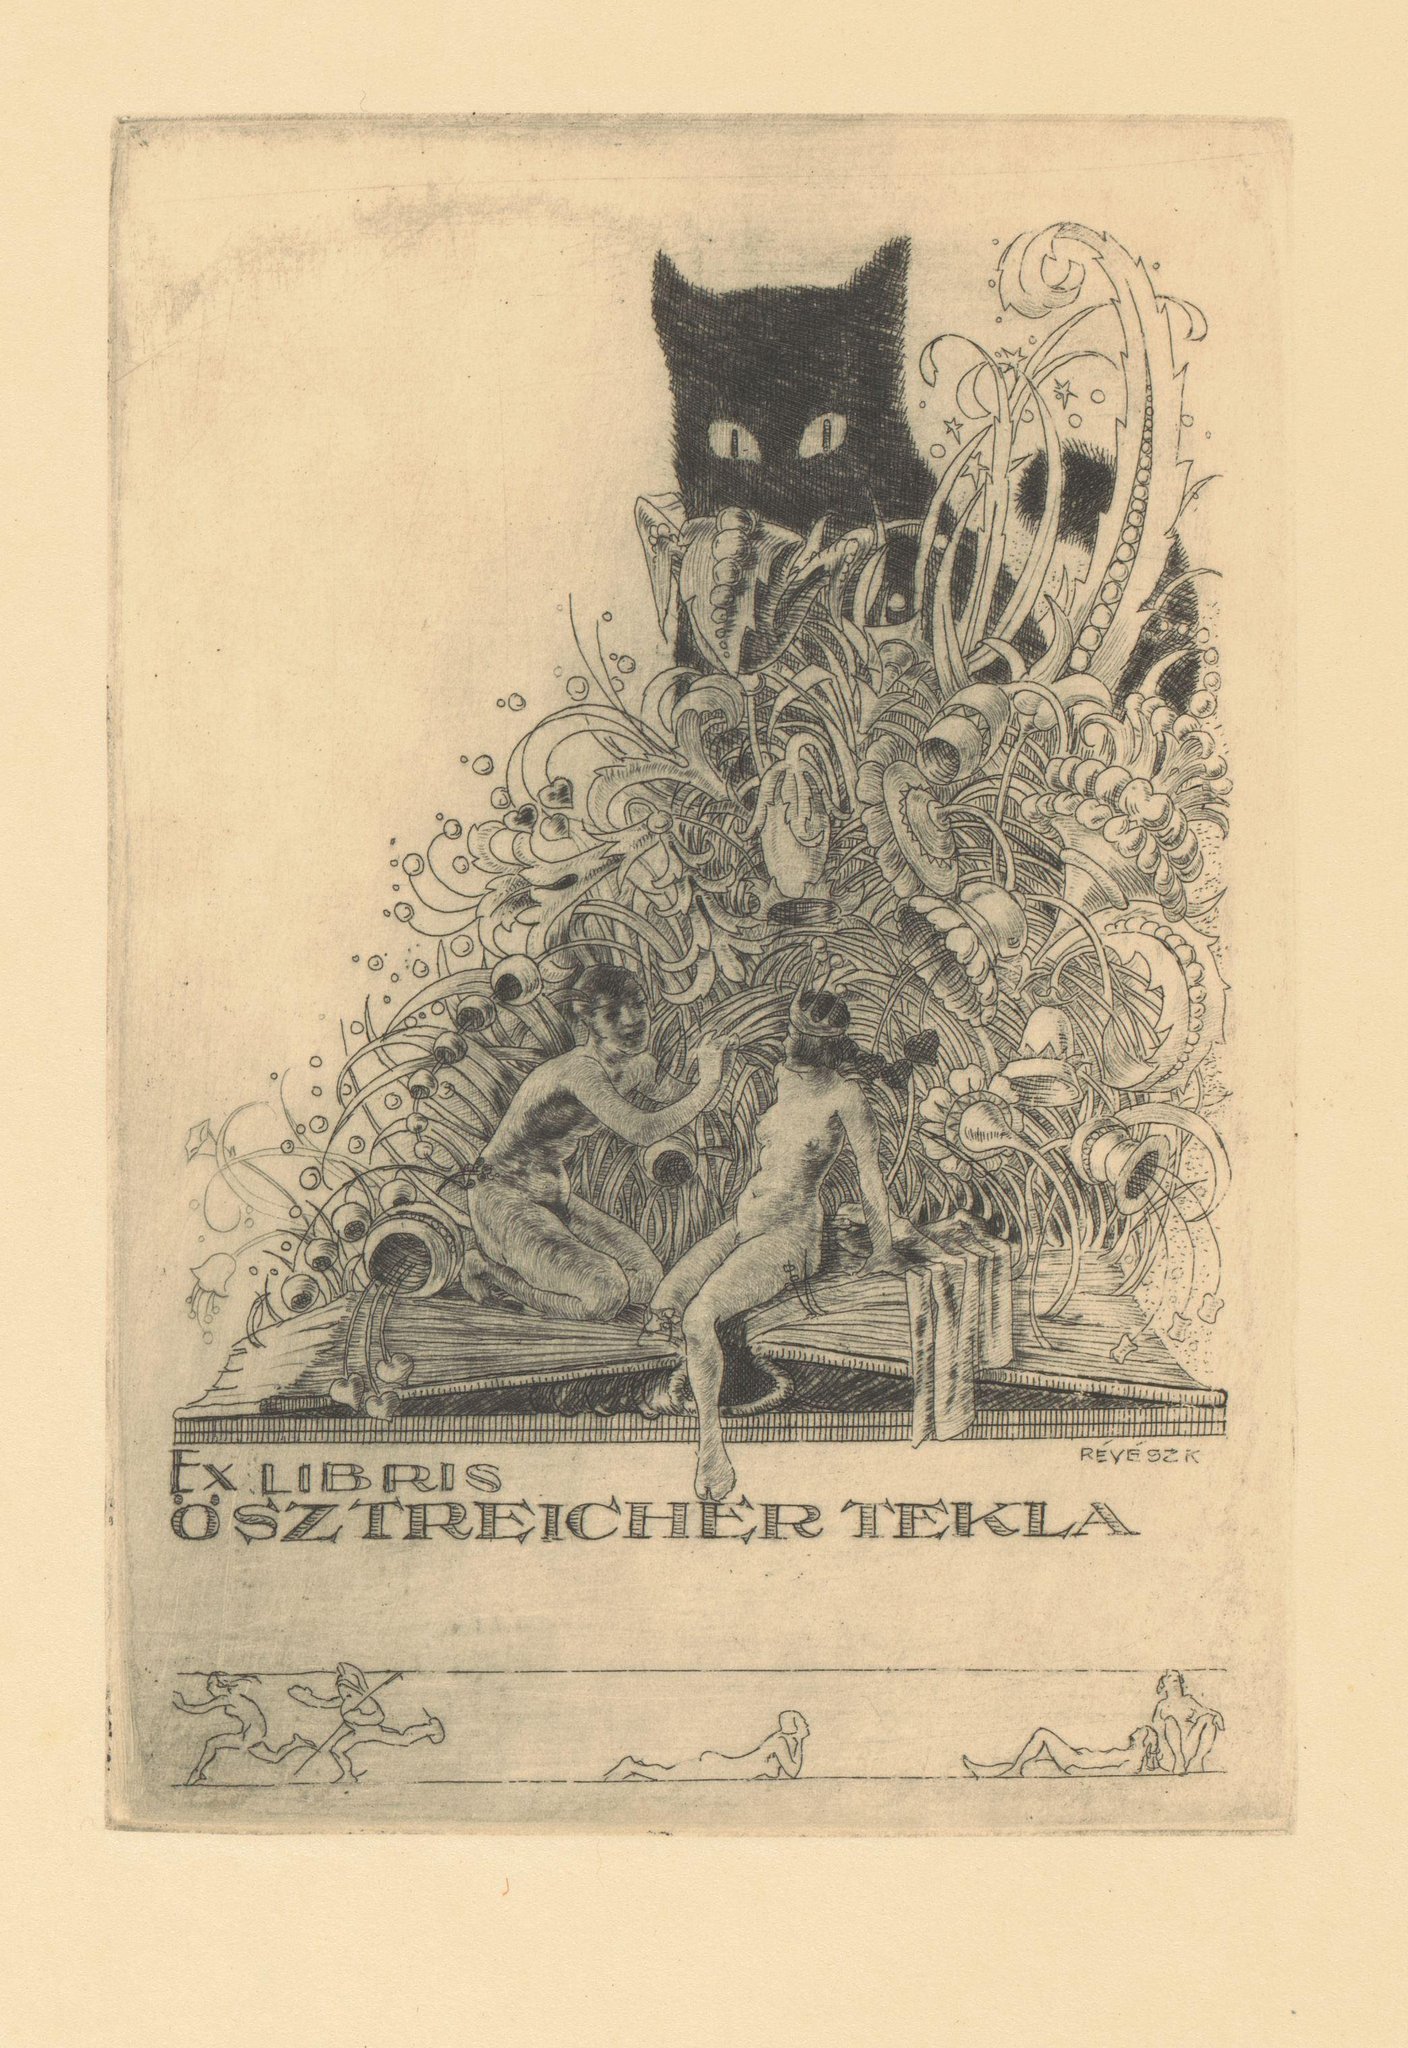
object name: bookplate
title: Ex libris van Tekla Ösztreicher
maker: kornél révész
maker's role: print maker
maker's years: 1885-1944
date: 1893-1936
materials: paper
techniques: drypoint, etching, intaglio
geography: hungary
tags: print maker, tekla ösztreicher-bakonyi, cat, fantastic plants, fabulous vegetation, woman (showing herself) undressed, quasi-nude, book, man (showing himself) undressed, quasi-nude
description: Prent is deel van een catalogus met 13 ingebonden objecten en twee tekstbladen. Catalogus is deel van een omslag met 64 objecten op 34 opzetvellen en een tekstblad.